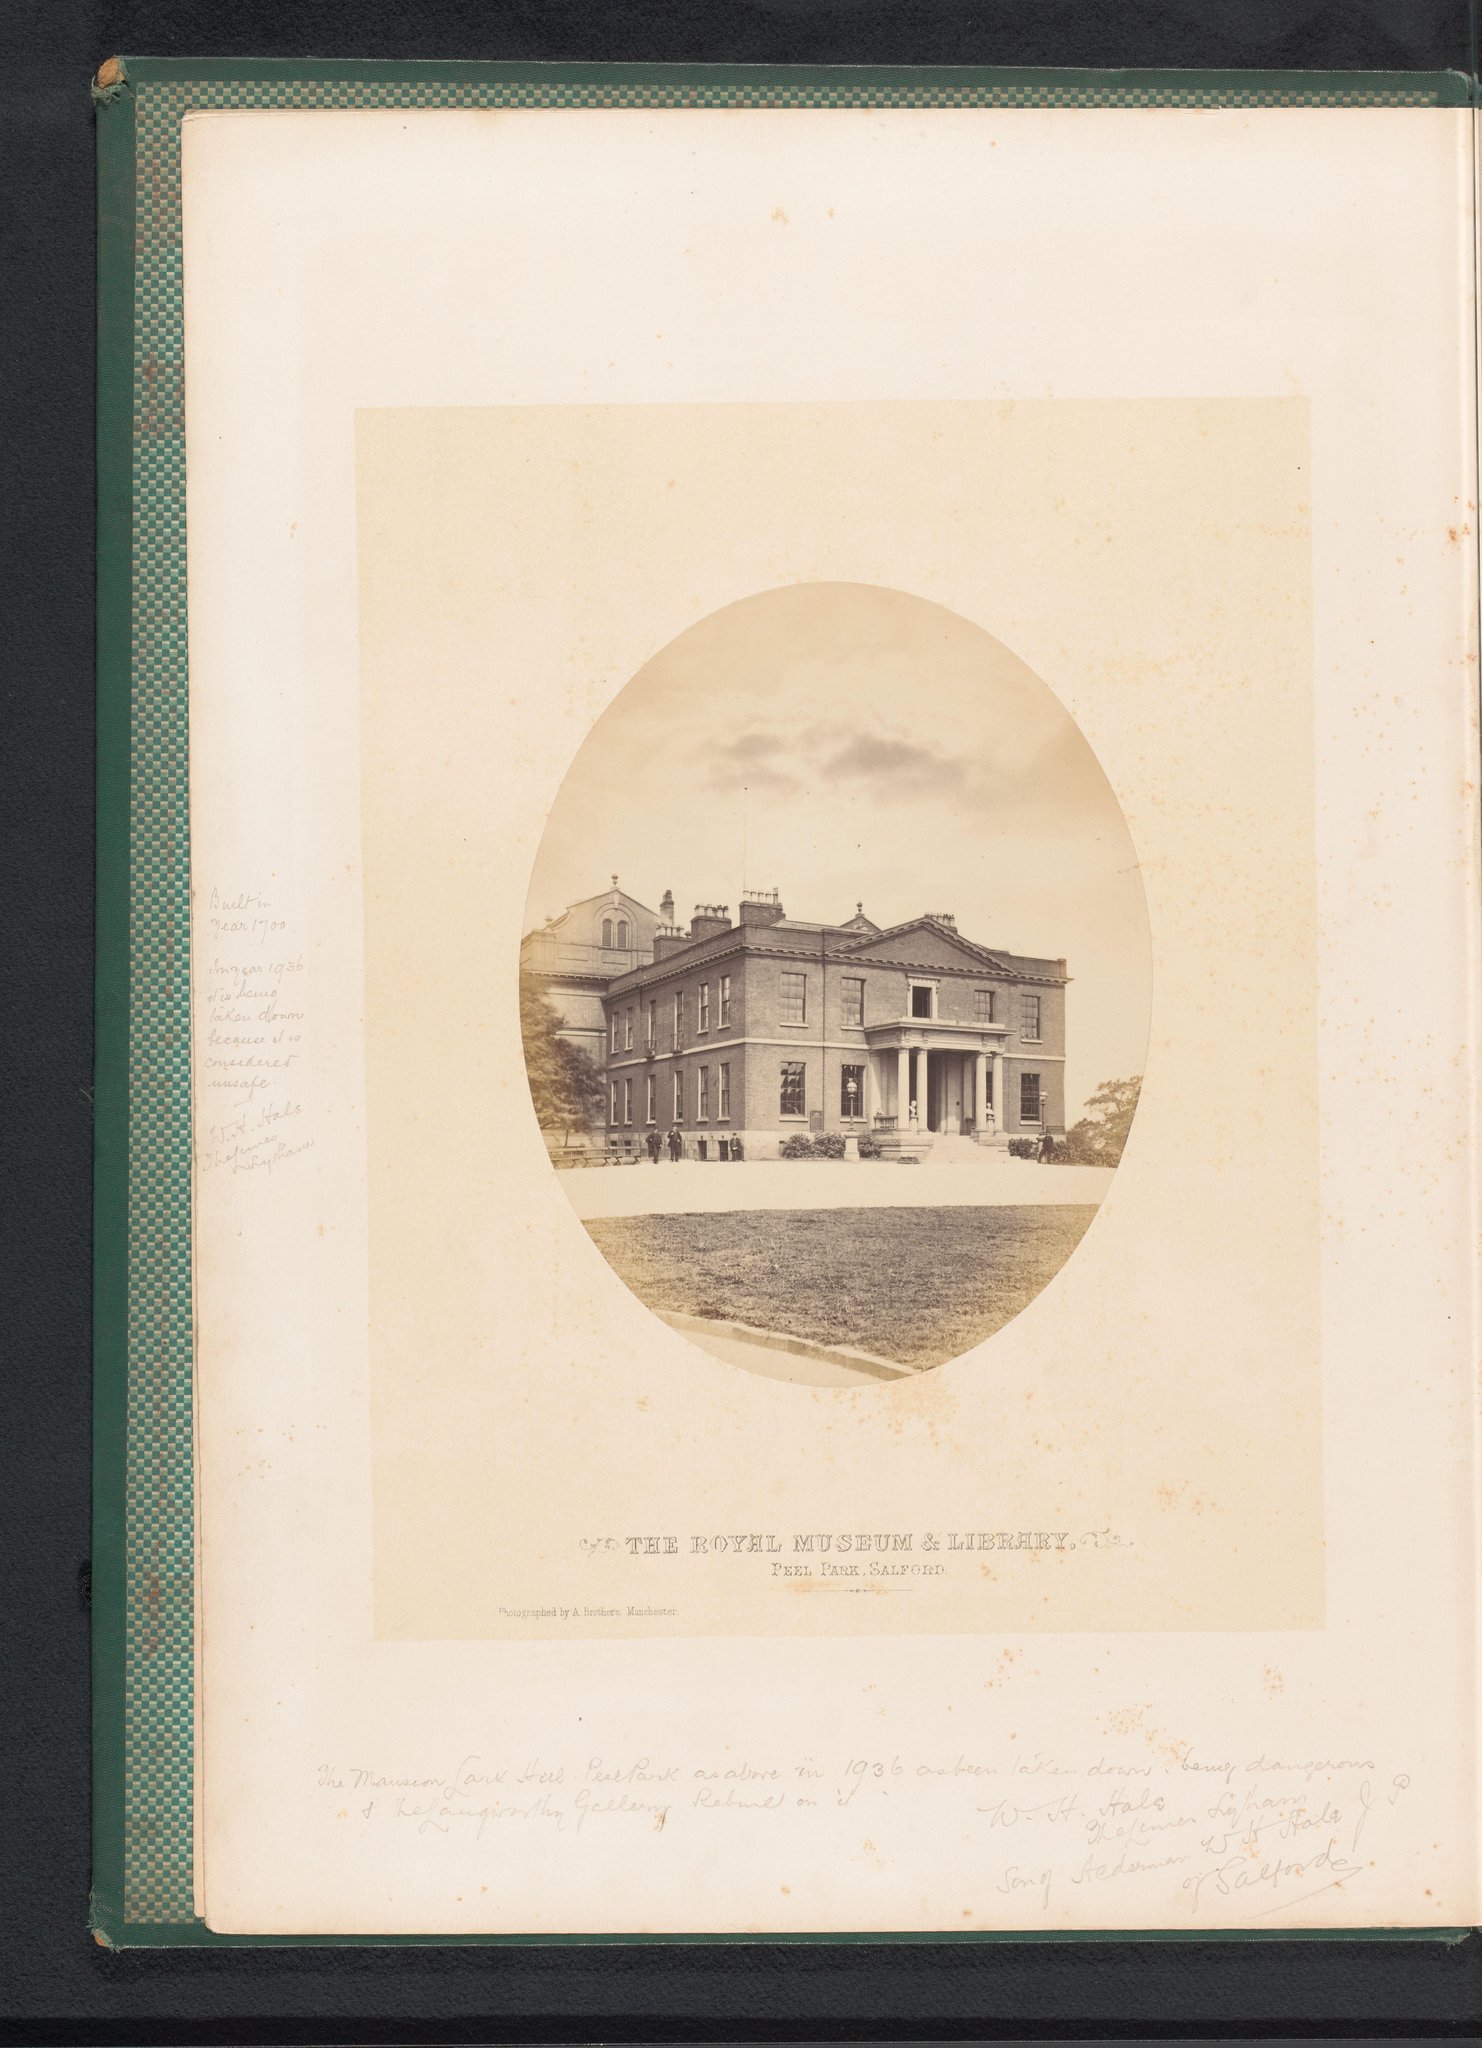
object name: page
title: Gezicht op The Royal Museum and Public Library in Salford, Engeland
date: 1863-1868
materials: photographic support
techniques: albumen print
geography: salford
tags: permanent exhibition, museum, public library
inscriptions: annotation: ‘Built in (...) of Salford.’, inscription: ‘Peel Park, Salford.’